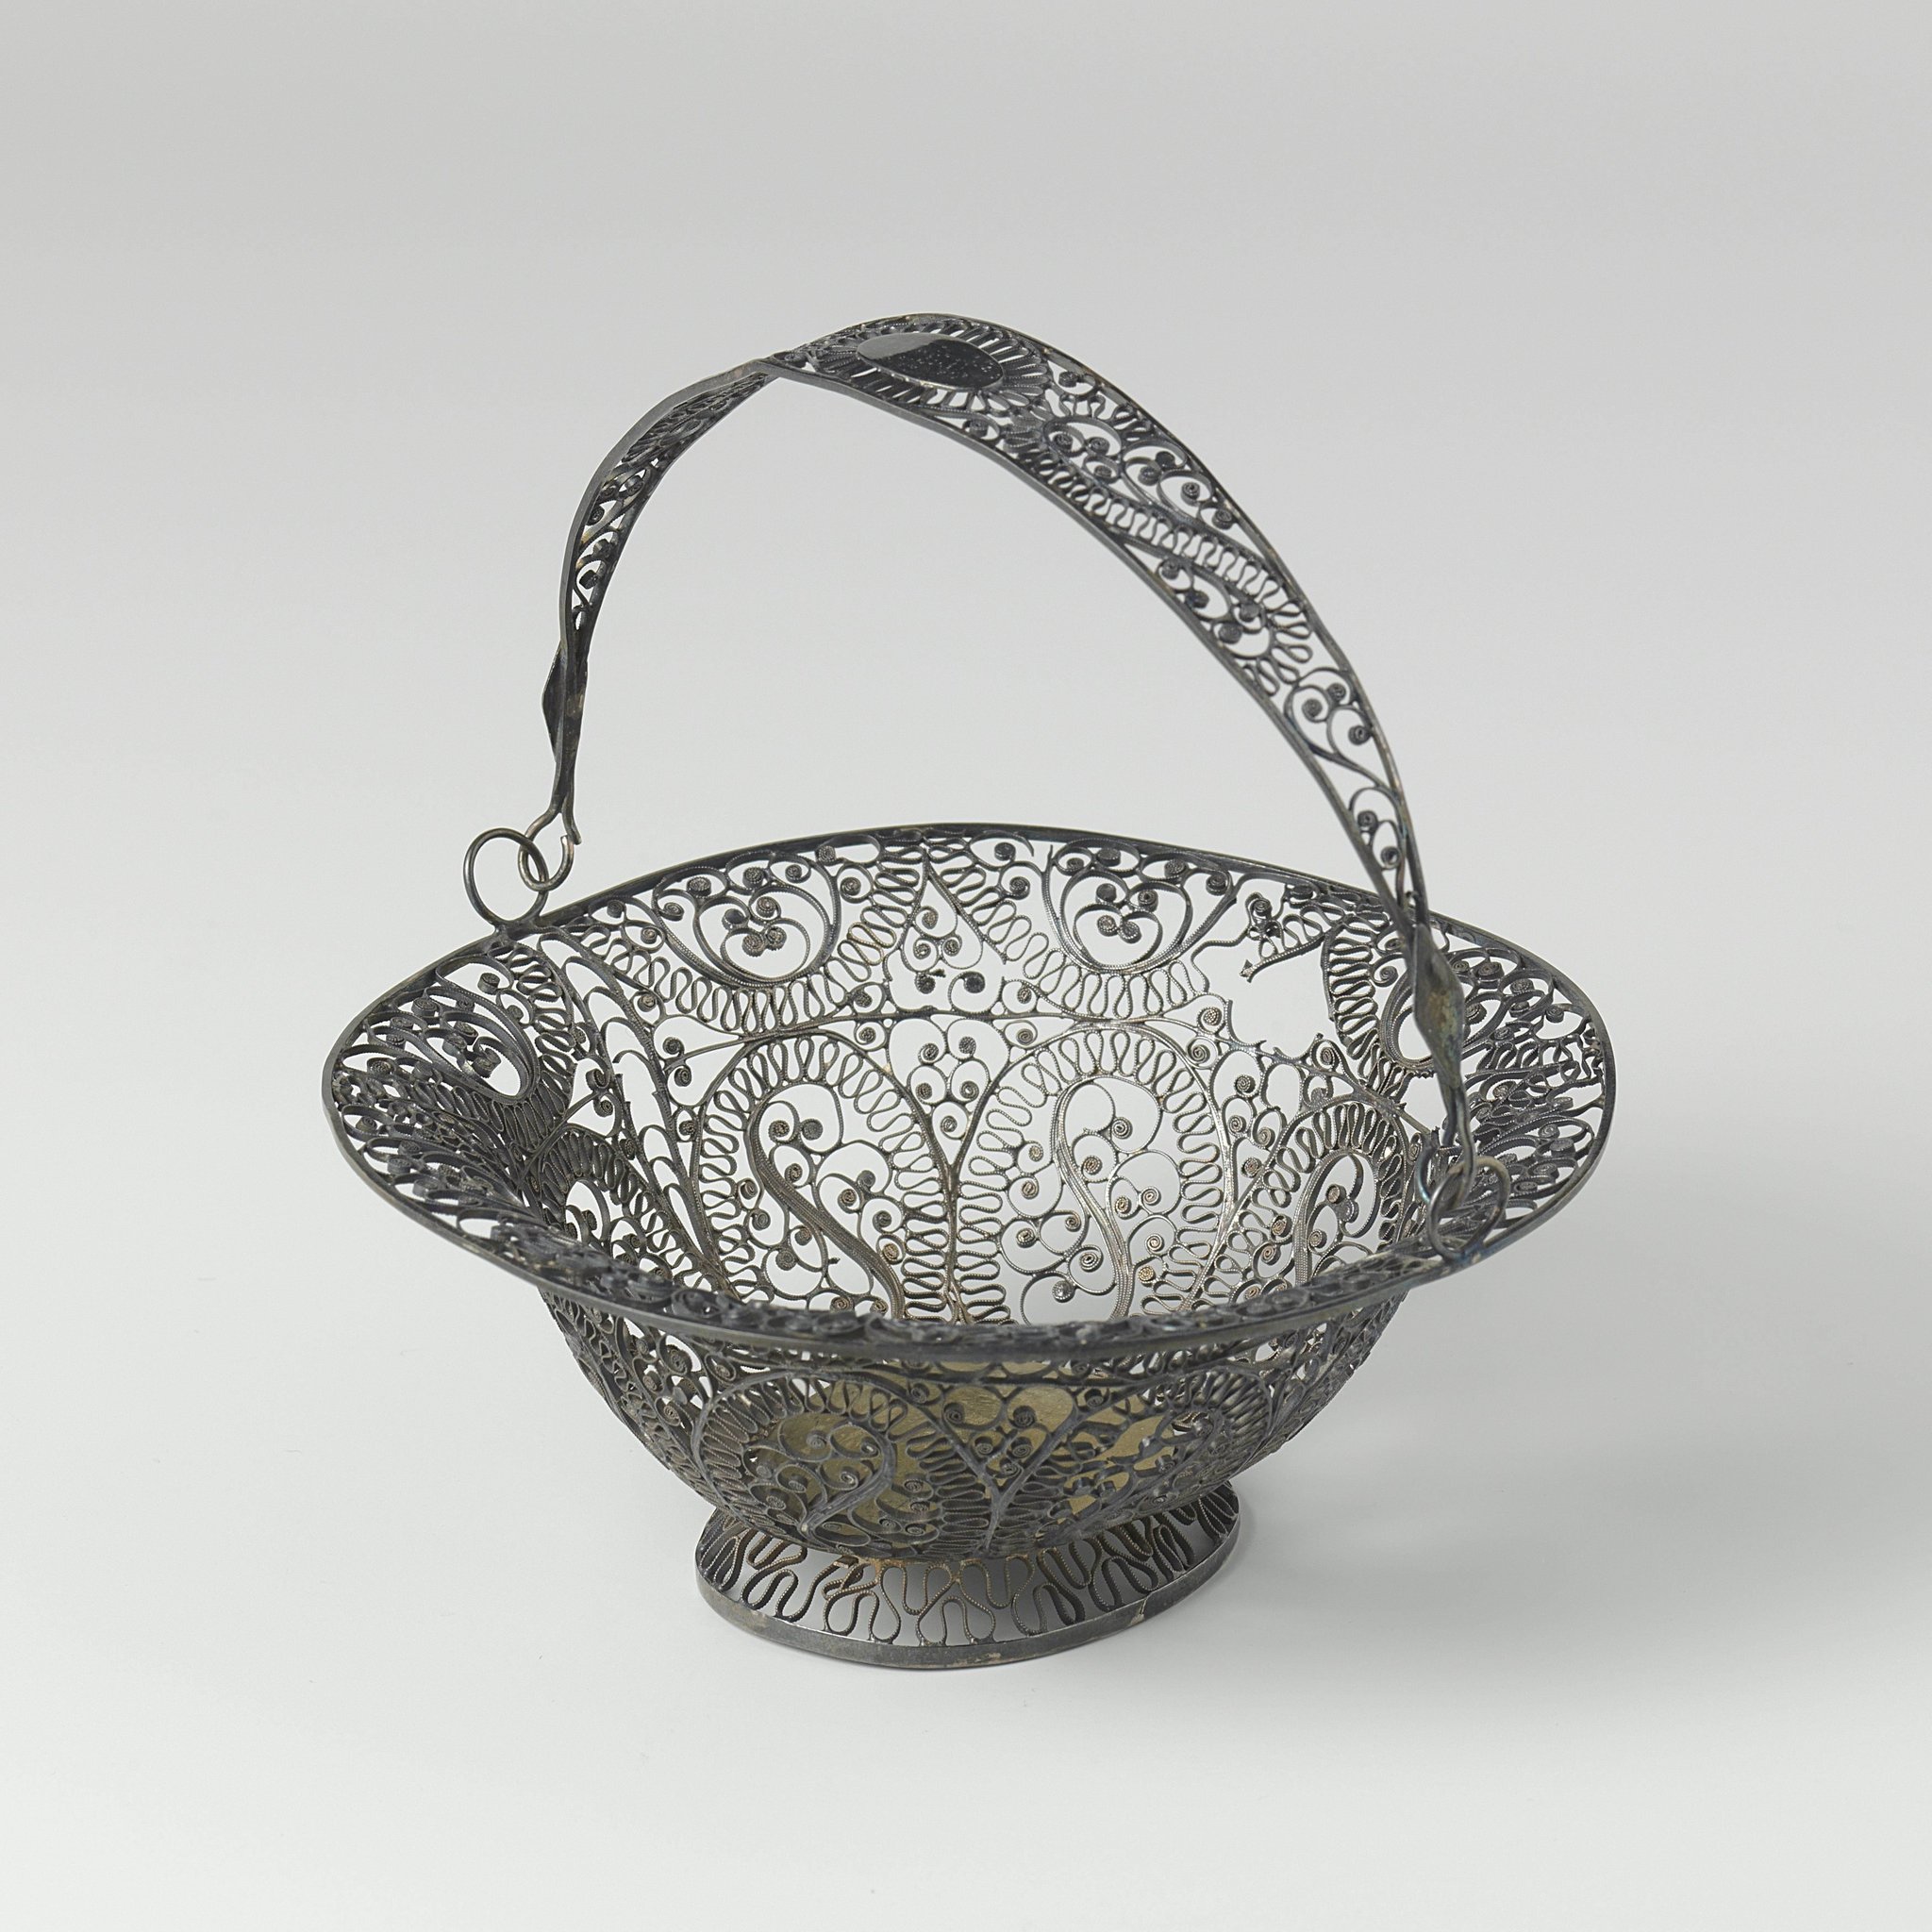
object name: miniature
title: Hengselmand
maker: Anonymous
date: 1800-1900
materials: silver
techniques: filigree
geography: europe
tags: container of metal: bucket, can, canister, drum, tin